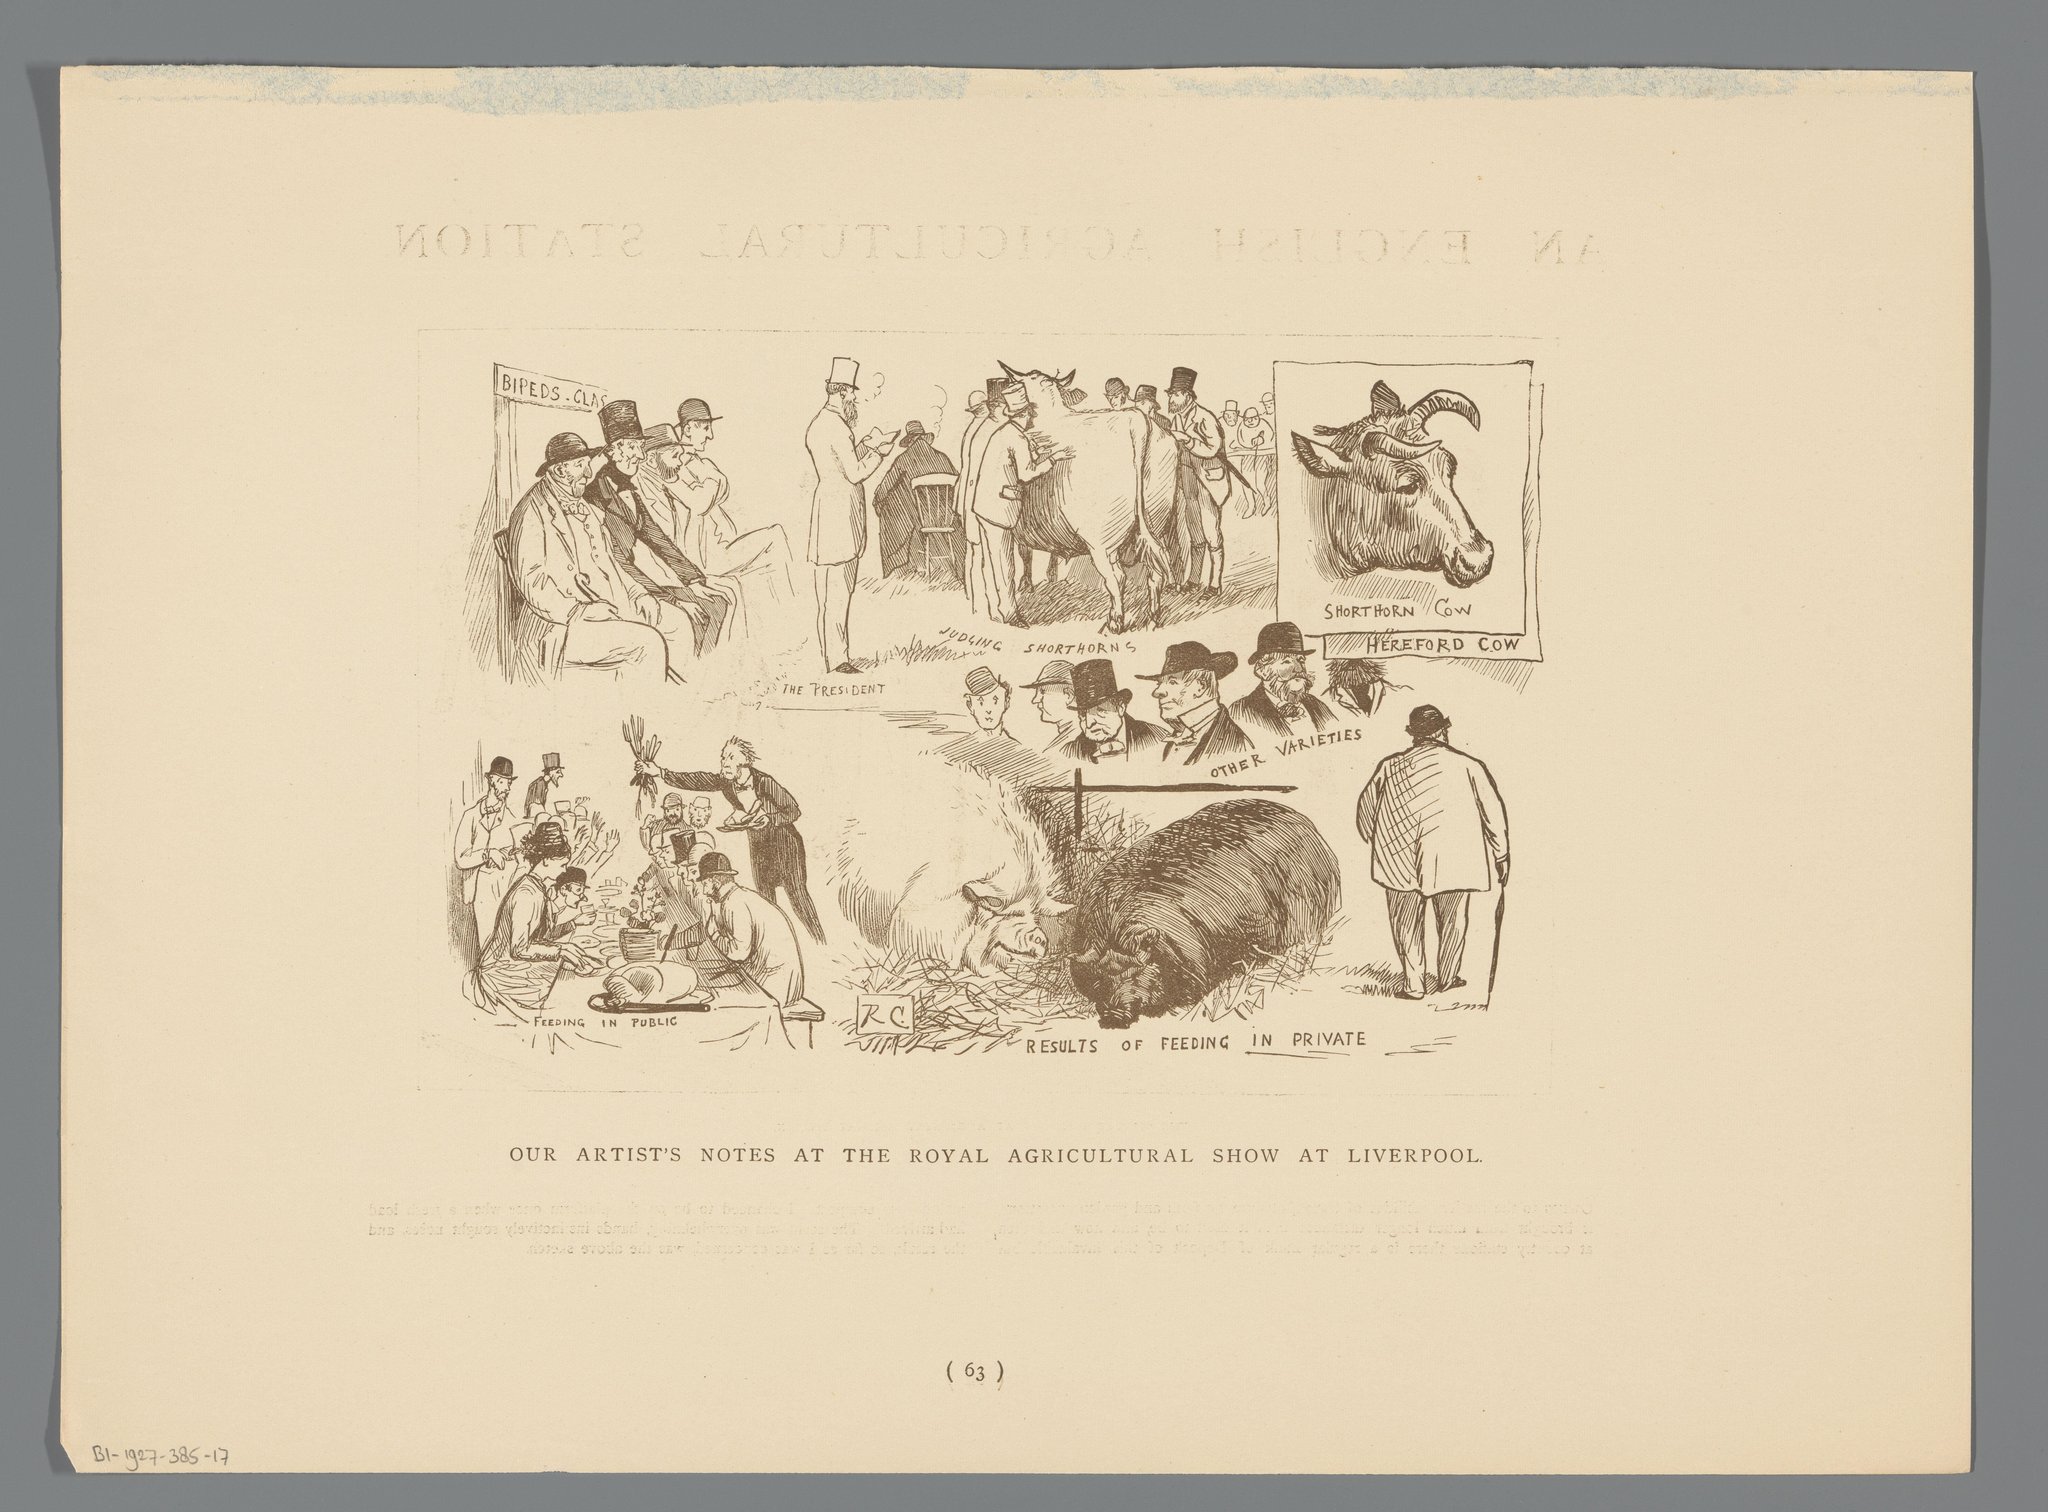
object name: book illustration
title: Our artist's notes at the Royal Agiculutral Show at Liverpool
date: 1889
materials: paper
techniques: letterpress printing, engraving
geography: london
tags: cattle, adult man (+ more than eight persons), agriculture, eating, liverpool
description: Prent uit: Gleanings from the Graphic. Londen: George Routledge & Sons, 1889. Dit werk is een bundel van diverse illustraties die eerder verschenen in verschillende jaargangen van het Engelse weekblad 'The Graphic'. De bundel is na het overlijden van Randolph Caldecott uitgegeven.